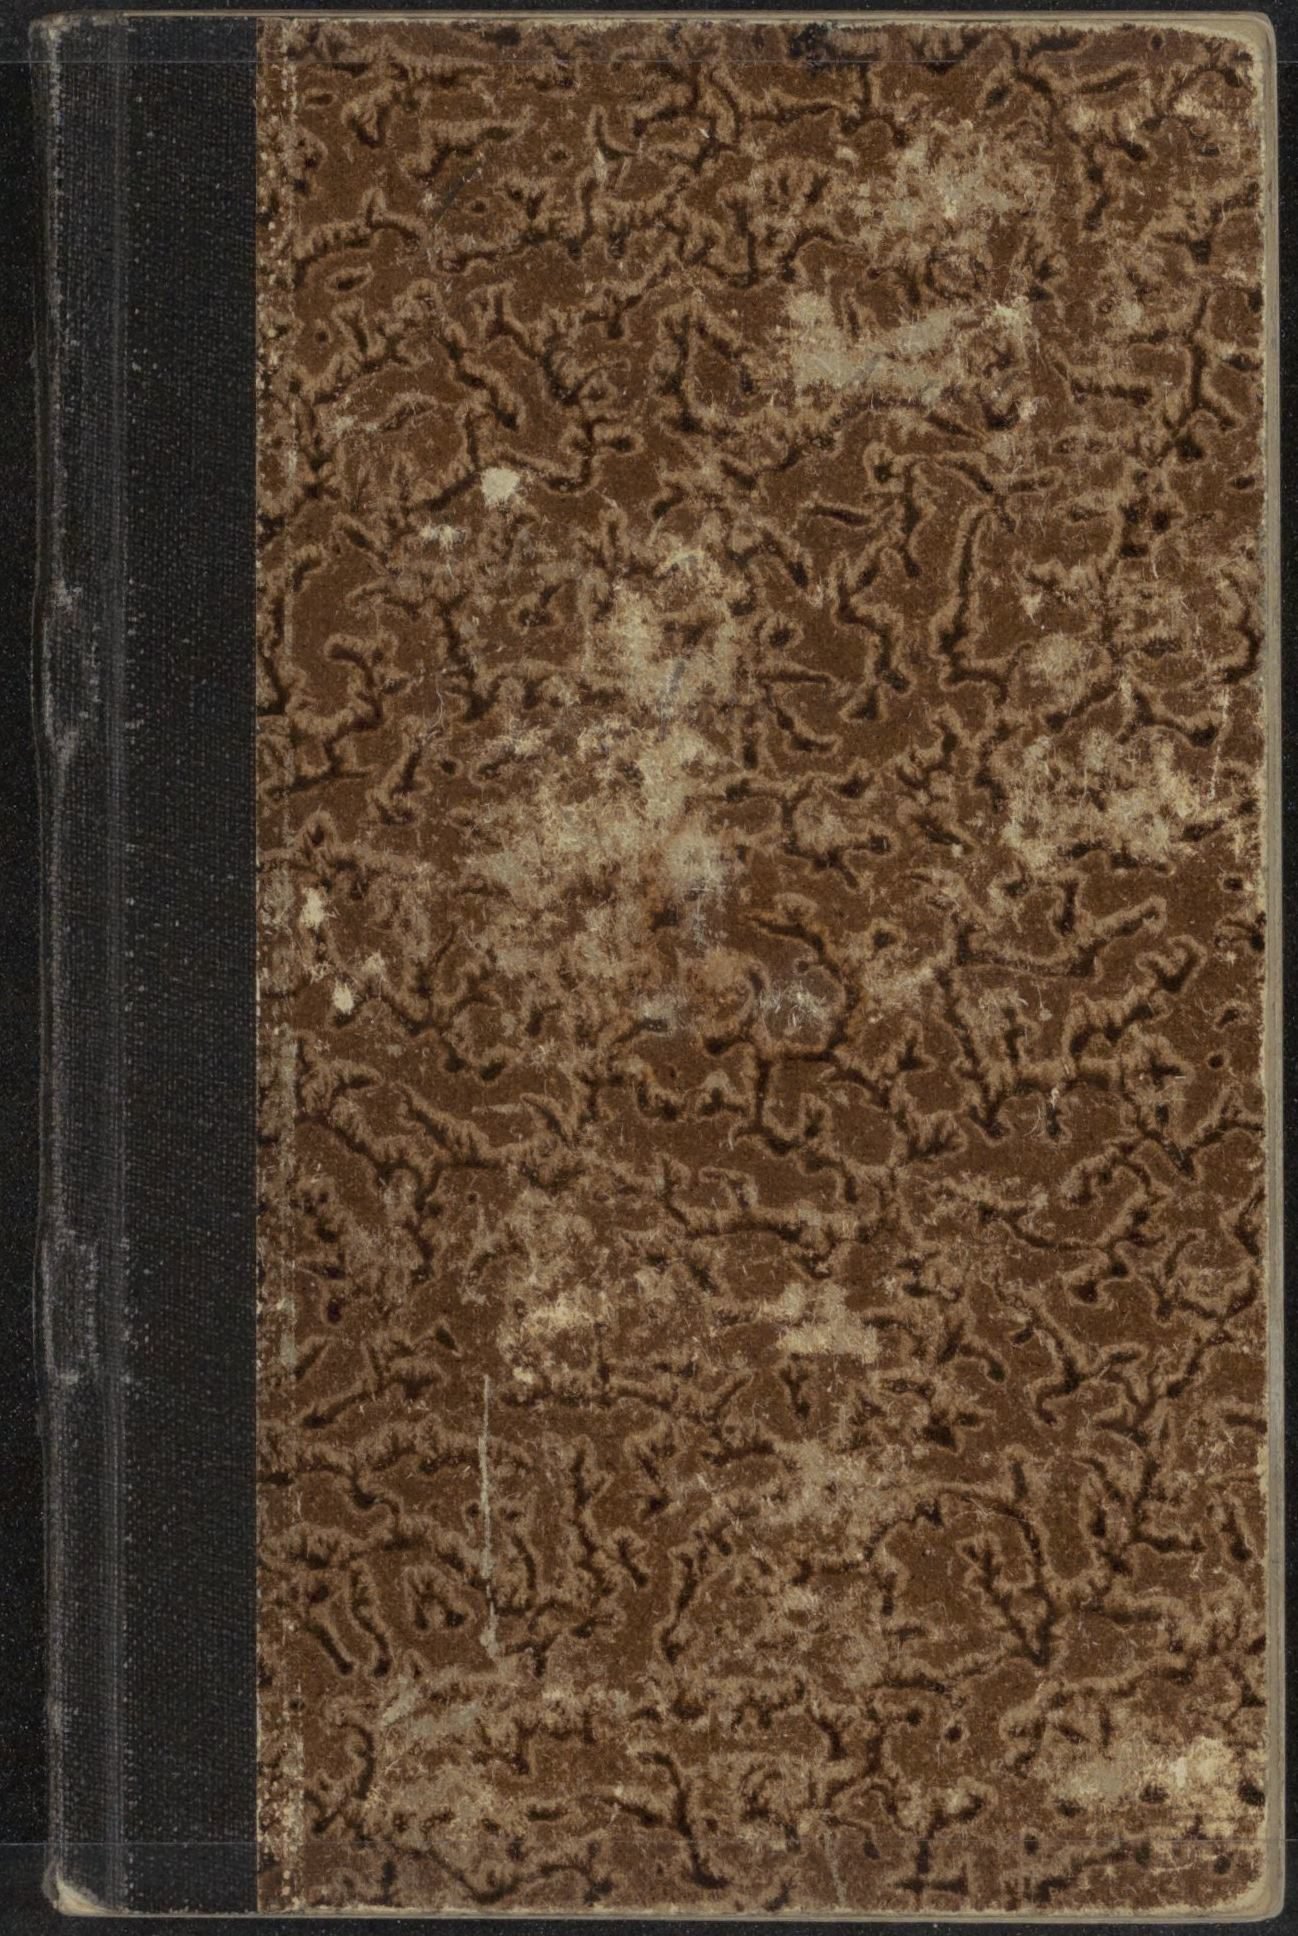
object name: sketchbook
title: Schetsboek met 46 bladen vervaardigd te Antwerpen, Gent en Amsterdam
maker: george hendrik breitner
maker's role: draughtsman, painter, print maker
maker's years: 1857-1923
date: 1907-1909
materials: cardboard, chalk, linen, paper, pencil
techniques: marbling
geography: amsterdam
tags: city-view, and landscape with man-made constructions, street, antwerp, ghent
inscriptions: annotation: ‘Gent/ Antwerpen/ Damrak/ Teertuinen’, retailer's mark: ‘Gebrs. Simons/ Amsterdam./ Filiaal/ Heiligenweg 34/ Kantoorboek & Papierhandel./ Linieer- en Perforeer-inrichting./ No. 141 B-form/ Bij nabestelling van dit boek, gelieve men/ bovenstaand nummer op te geven. / per doz f 1.60 per stuk 15’, date: ‘1907-1908’, date: ‘1908-1909’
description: Pagina 85 bevat een afdruk van een tekening op een blad dat niet meer aanwezig is (paard en wagen).